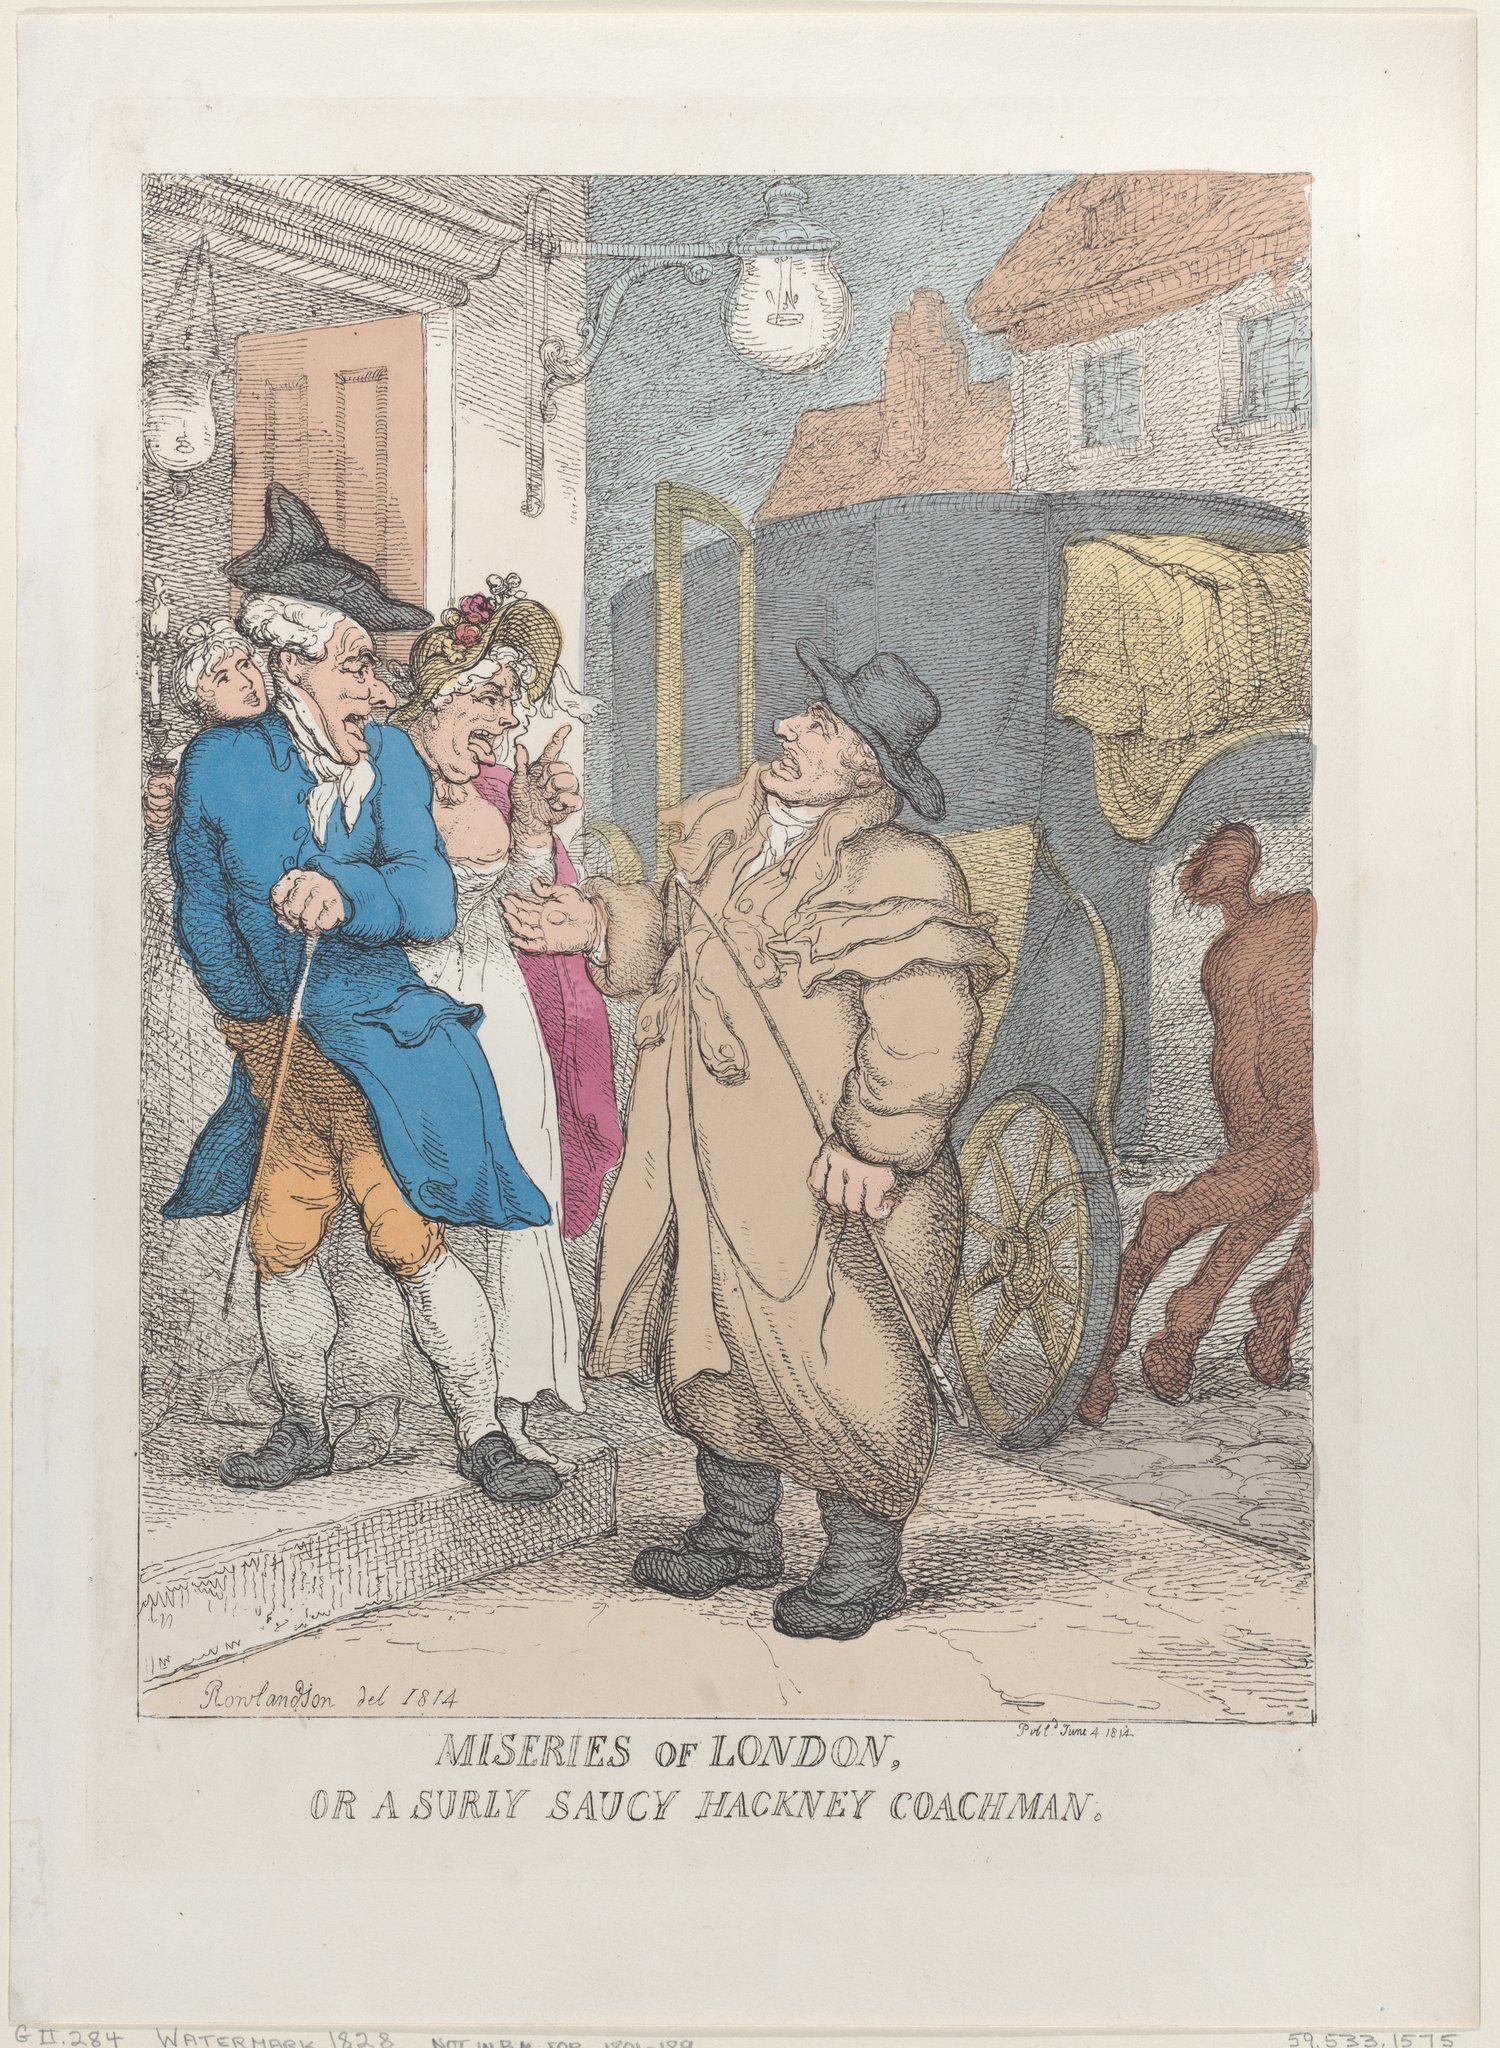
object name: print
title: Miseries of London, or a Surly Saucy Hackney Coachman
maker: thomas rowlandson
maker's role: artist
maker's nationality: british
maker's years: 1757-1827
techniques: etching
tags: satire,men,women